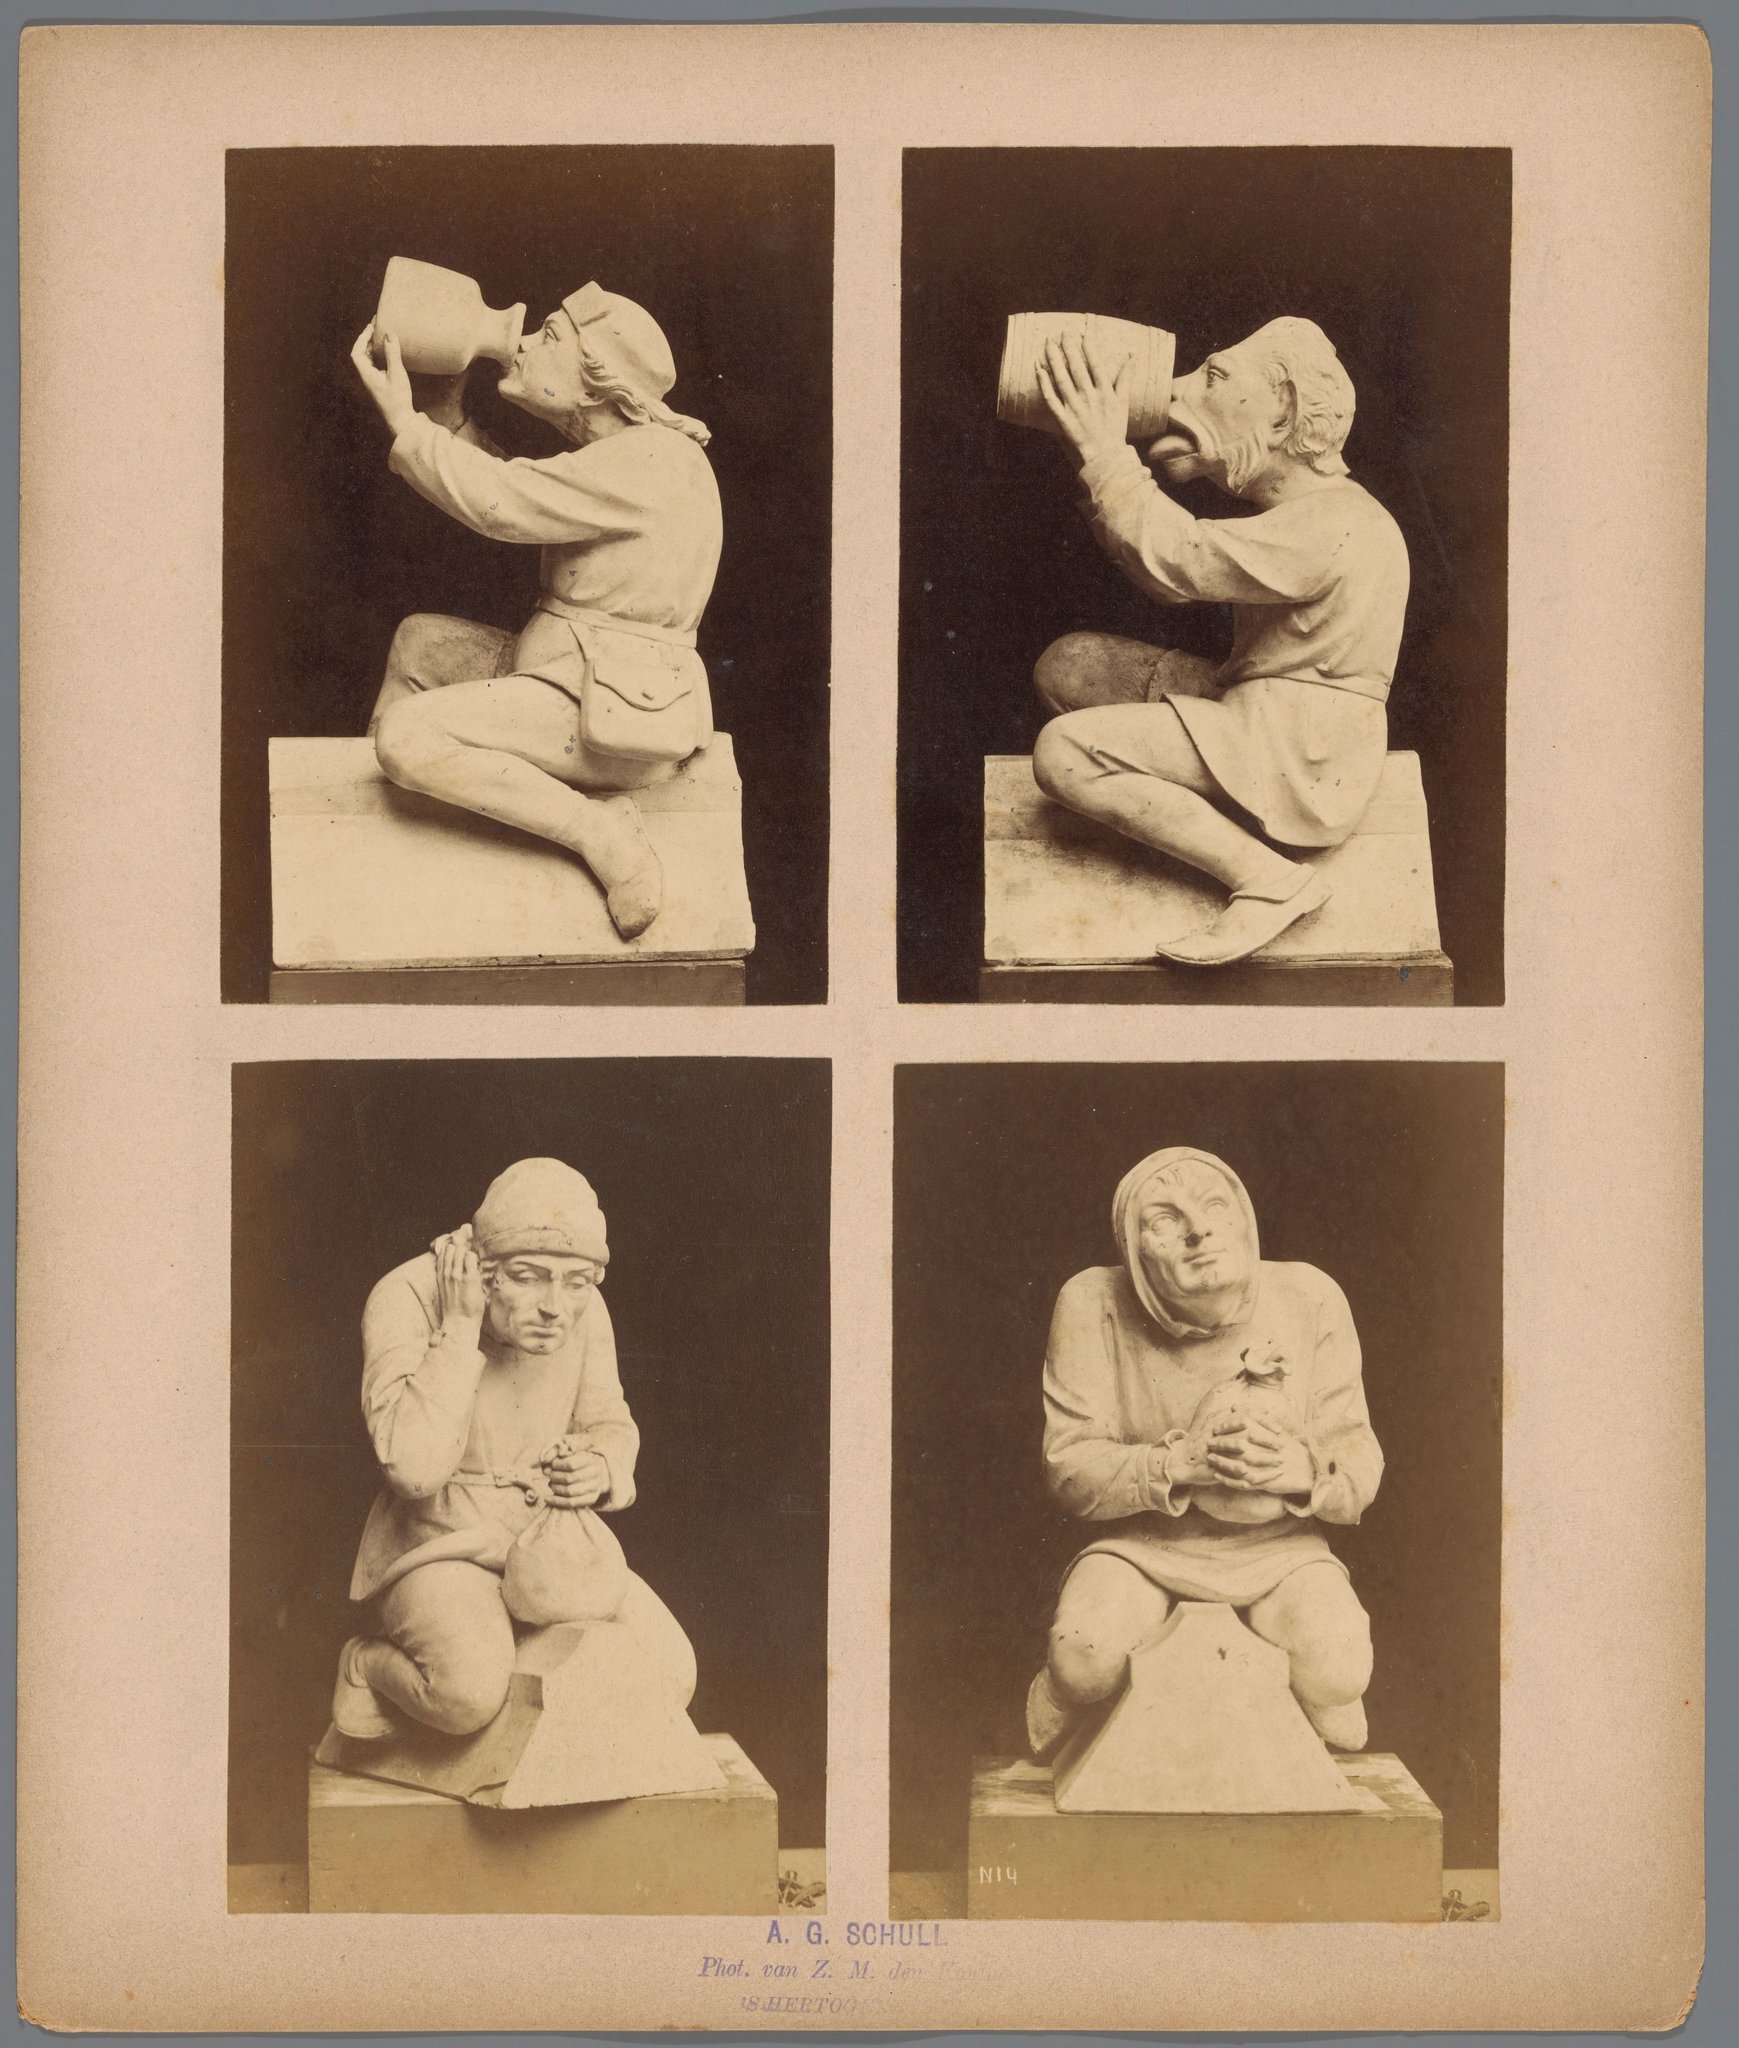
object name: photograph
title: Overzicht van vier luchtboogfiguren van de Sint-Janskathedraal te 's-Hertogenbosch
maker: antonius godefridus schull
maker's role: fotograaf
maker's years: 1819-1896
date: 1875-1900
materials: cardboard, photographic support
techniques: albumen print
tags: purse, money-bag, sculpture, drinking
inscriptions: name: ‘A. G. SCHULL Phot. van Z. M. den Koning 'S HERTOGENBOSCH’, number: ‘N14’, name: ‘S. FRANCO, b.i. den Haag.’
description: Linksboven een drinkende man, rechtsboven een drinkende figuur, linksonder een man met een buidel en rechtsonder een omhoogkijkende man met een buidel.